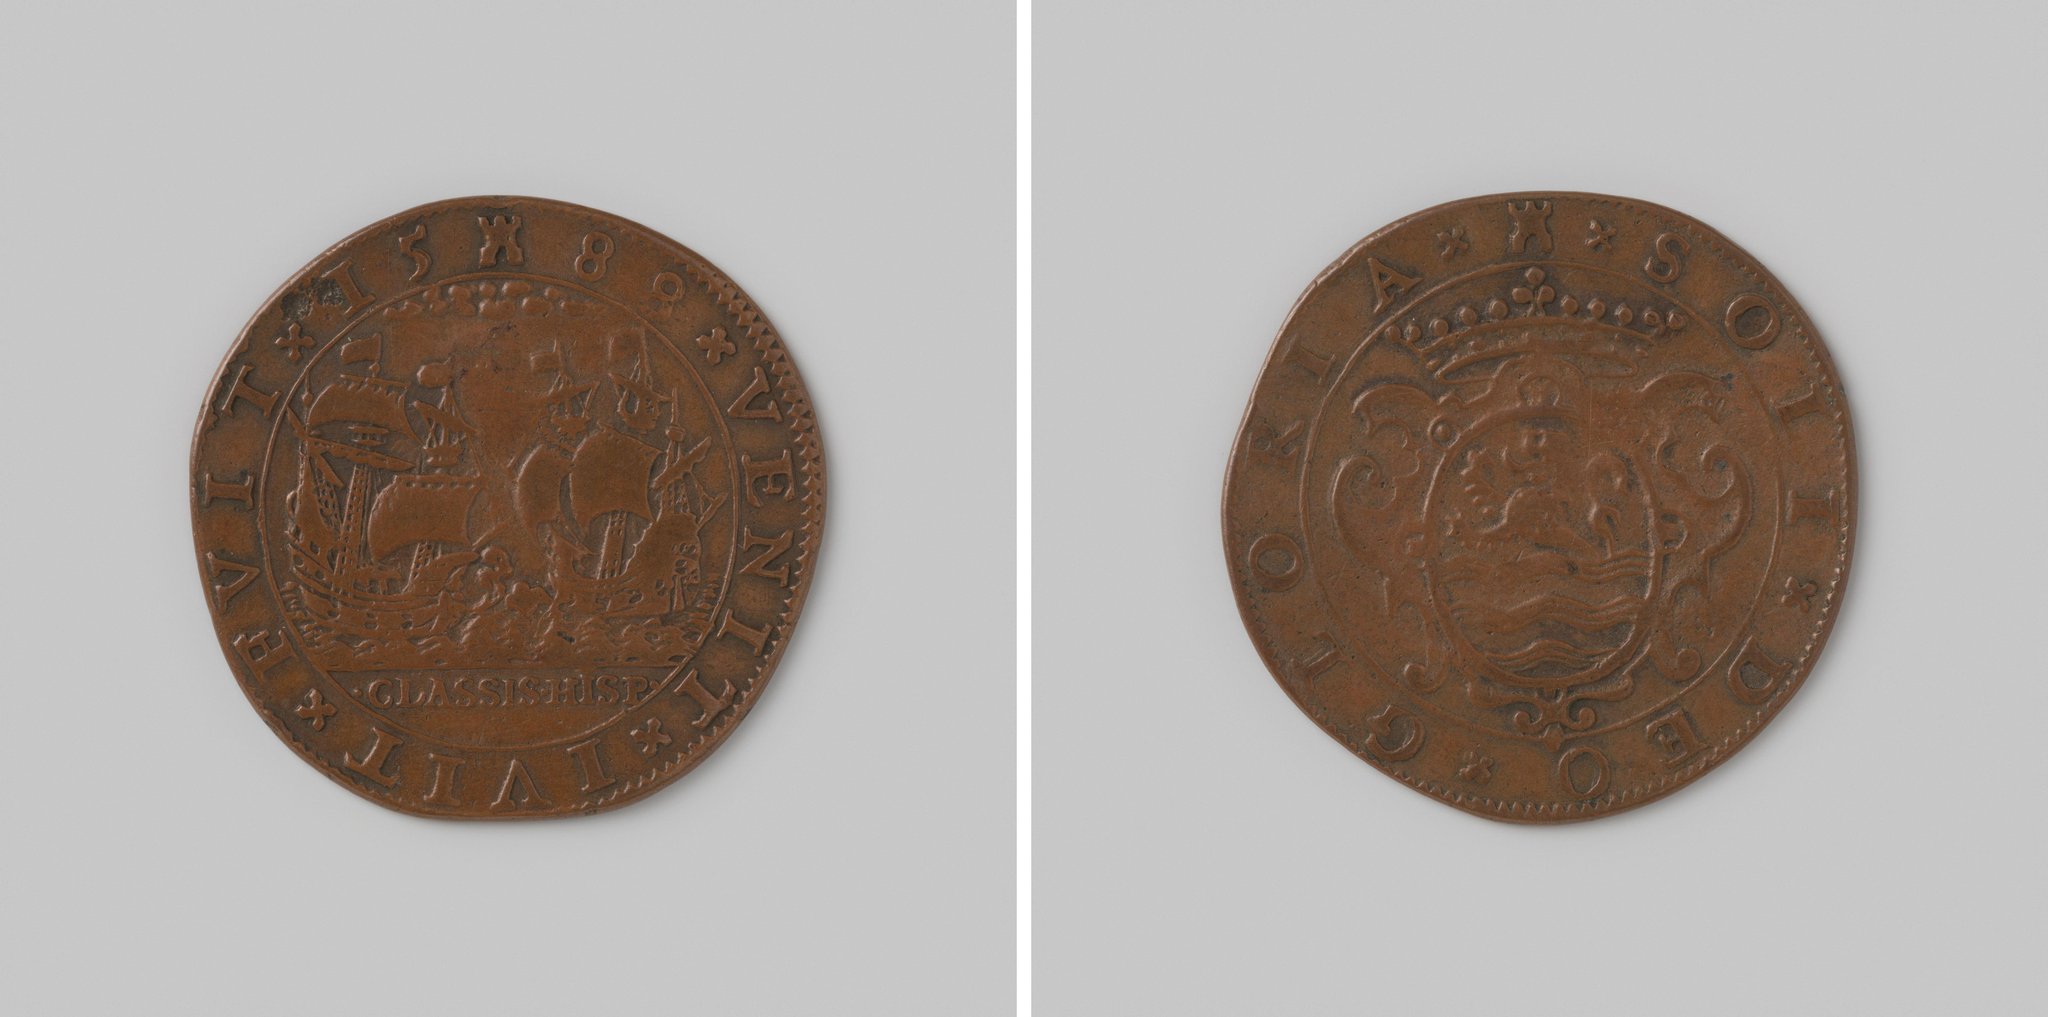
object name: history medal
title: Rekenpenning uit Middelburg op het verjagen van de Onoverwinnelijke Vloot 1588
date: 1588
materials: copper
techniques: striking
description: Koperen penning, op de voorzijde twee vechtende oorlogsschepen met afsnedetekst en omschrift, op de keerzijde het gekroonde wapenschild van Zeeland in cartouche met omschrift.